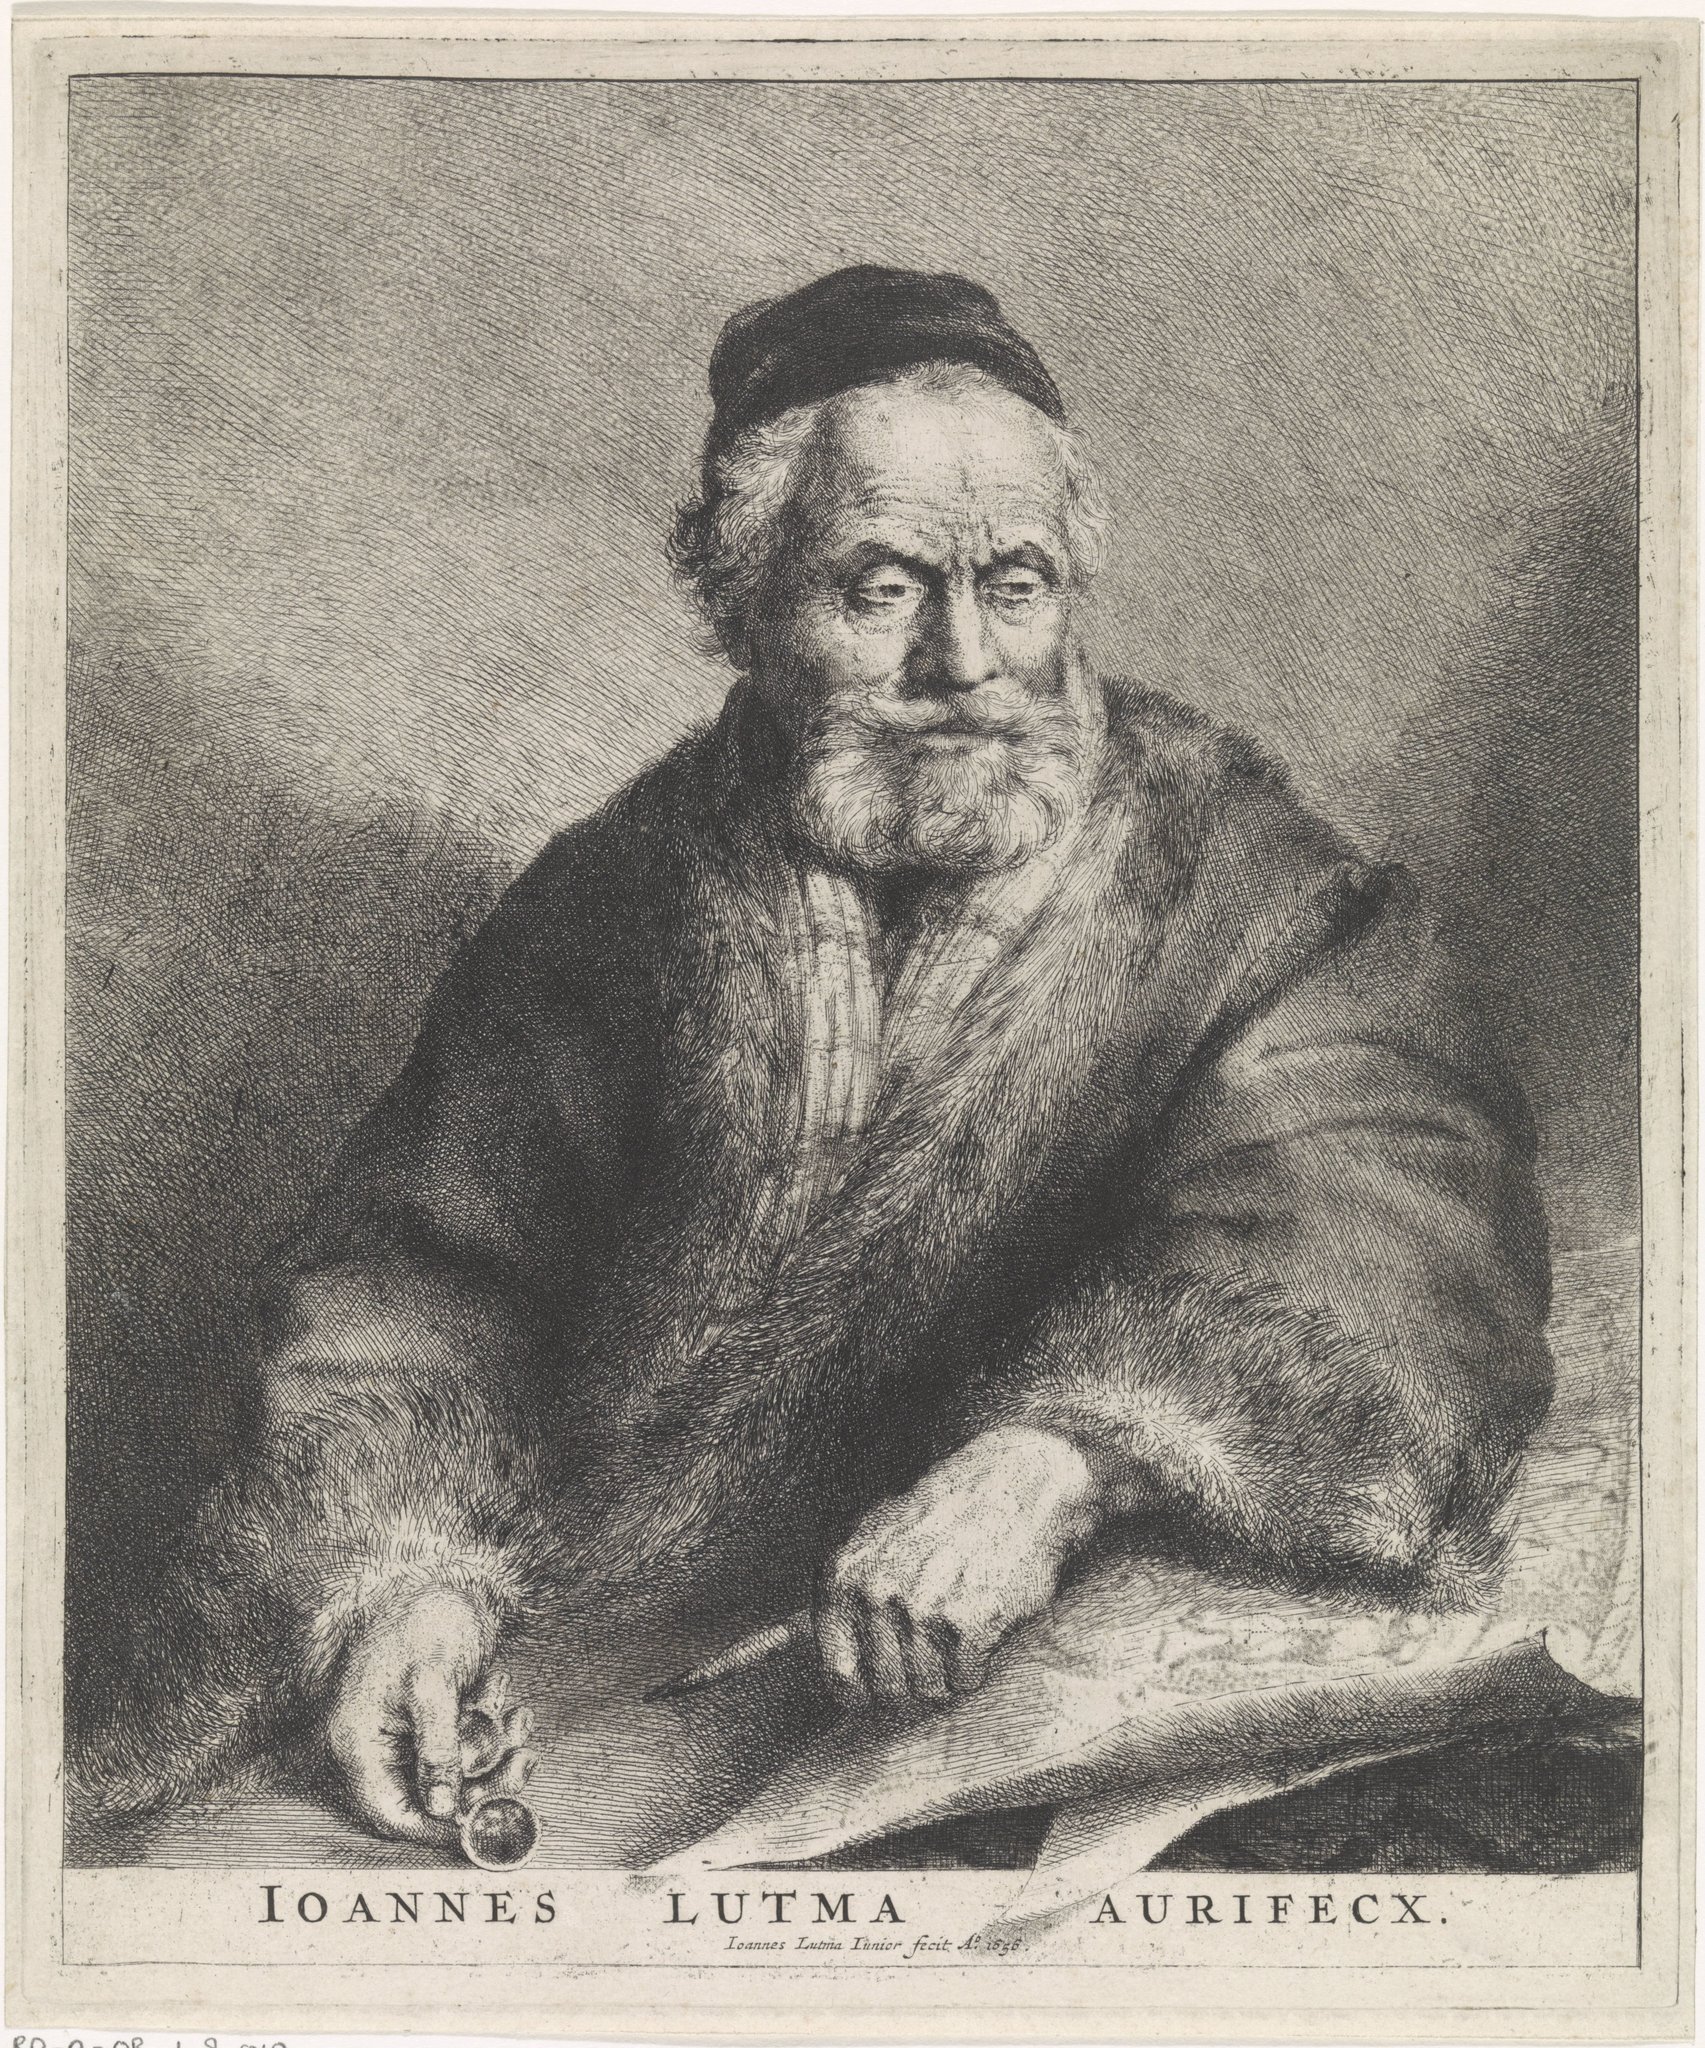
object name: print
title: Portret van de kunstenaar Johannes Lutma de Oude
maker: johannes lutma (1624-1689)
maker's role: print maker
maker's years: 1624-1689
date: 1656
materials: paper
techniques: etching, engraving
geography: amsterdam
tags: print maker, draughtsman, silversmith, johannes lutma (1584-1669)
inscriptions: collector's mark: Lugt 240